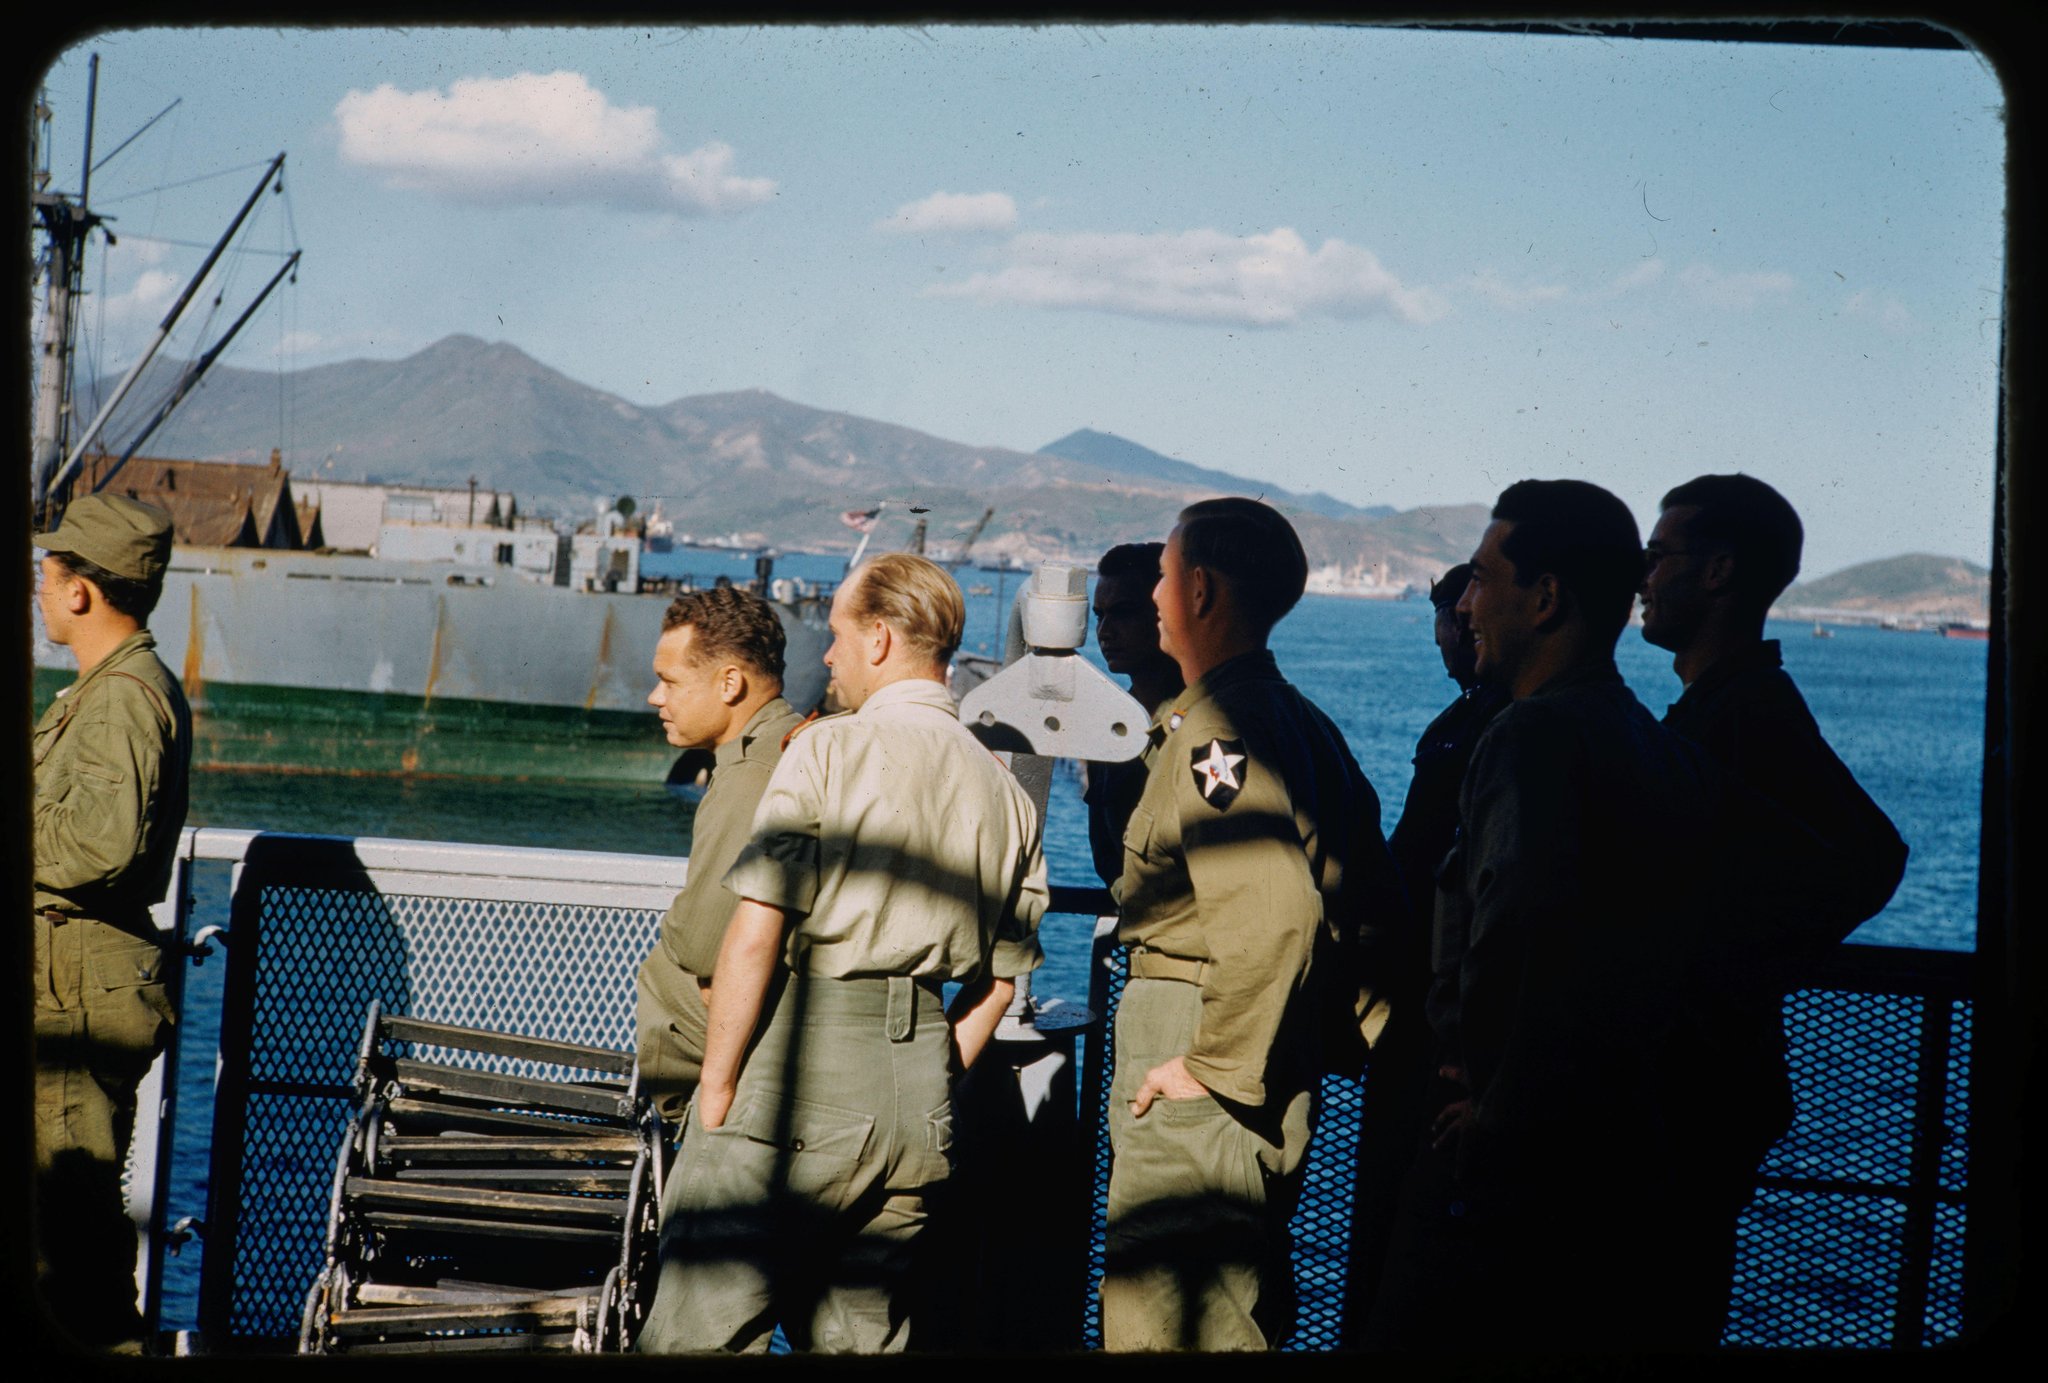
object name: color slide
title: Vertrekkende groep officieren uit Busan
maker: david ketel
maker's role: diplomaat, sinoloog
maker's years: 1913-2008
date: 1951-1953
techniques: slide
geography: korea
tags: united nations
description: Vertrekkende groep officieren uit Busan, waaronder majoor Teuling.